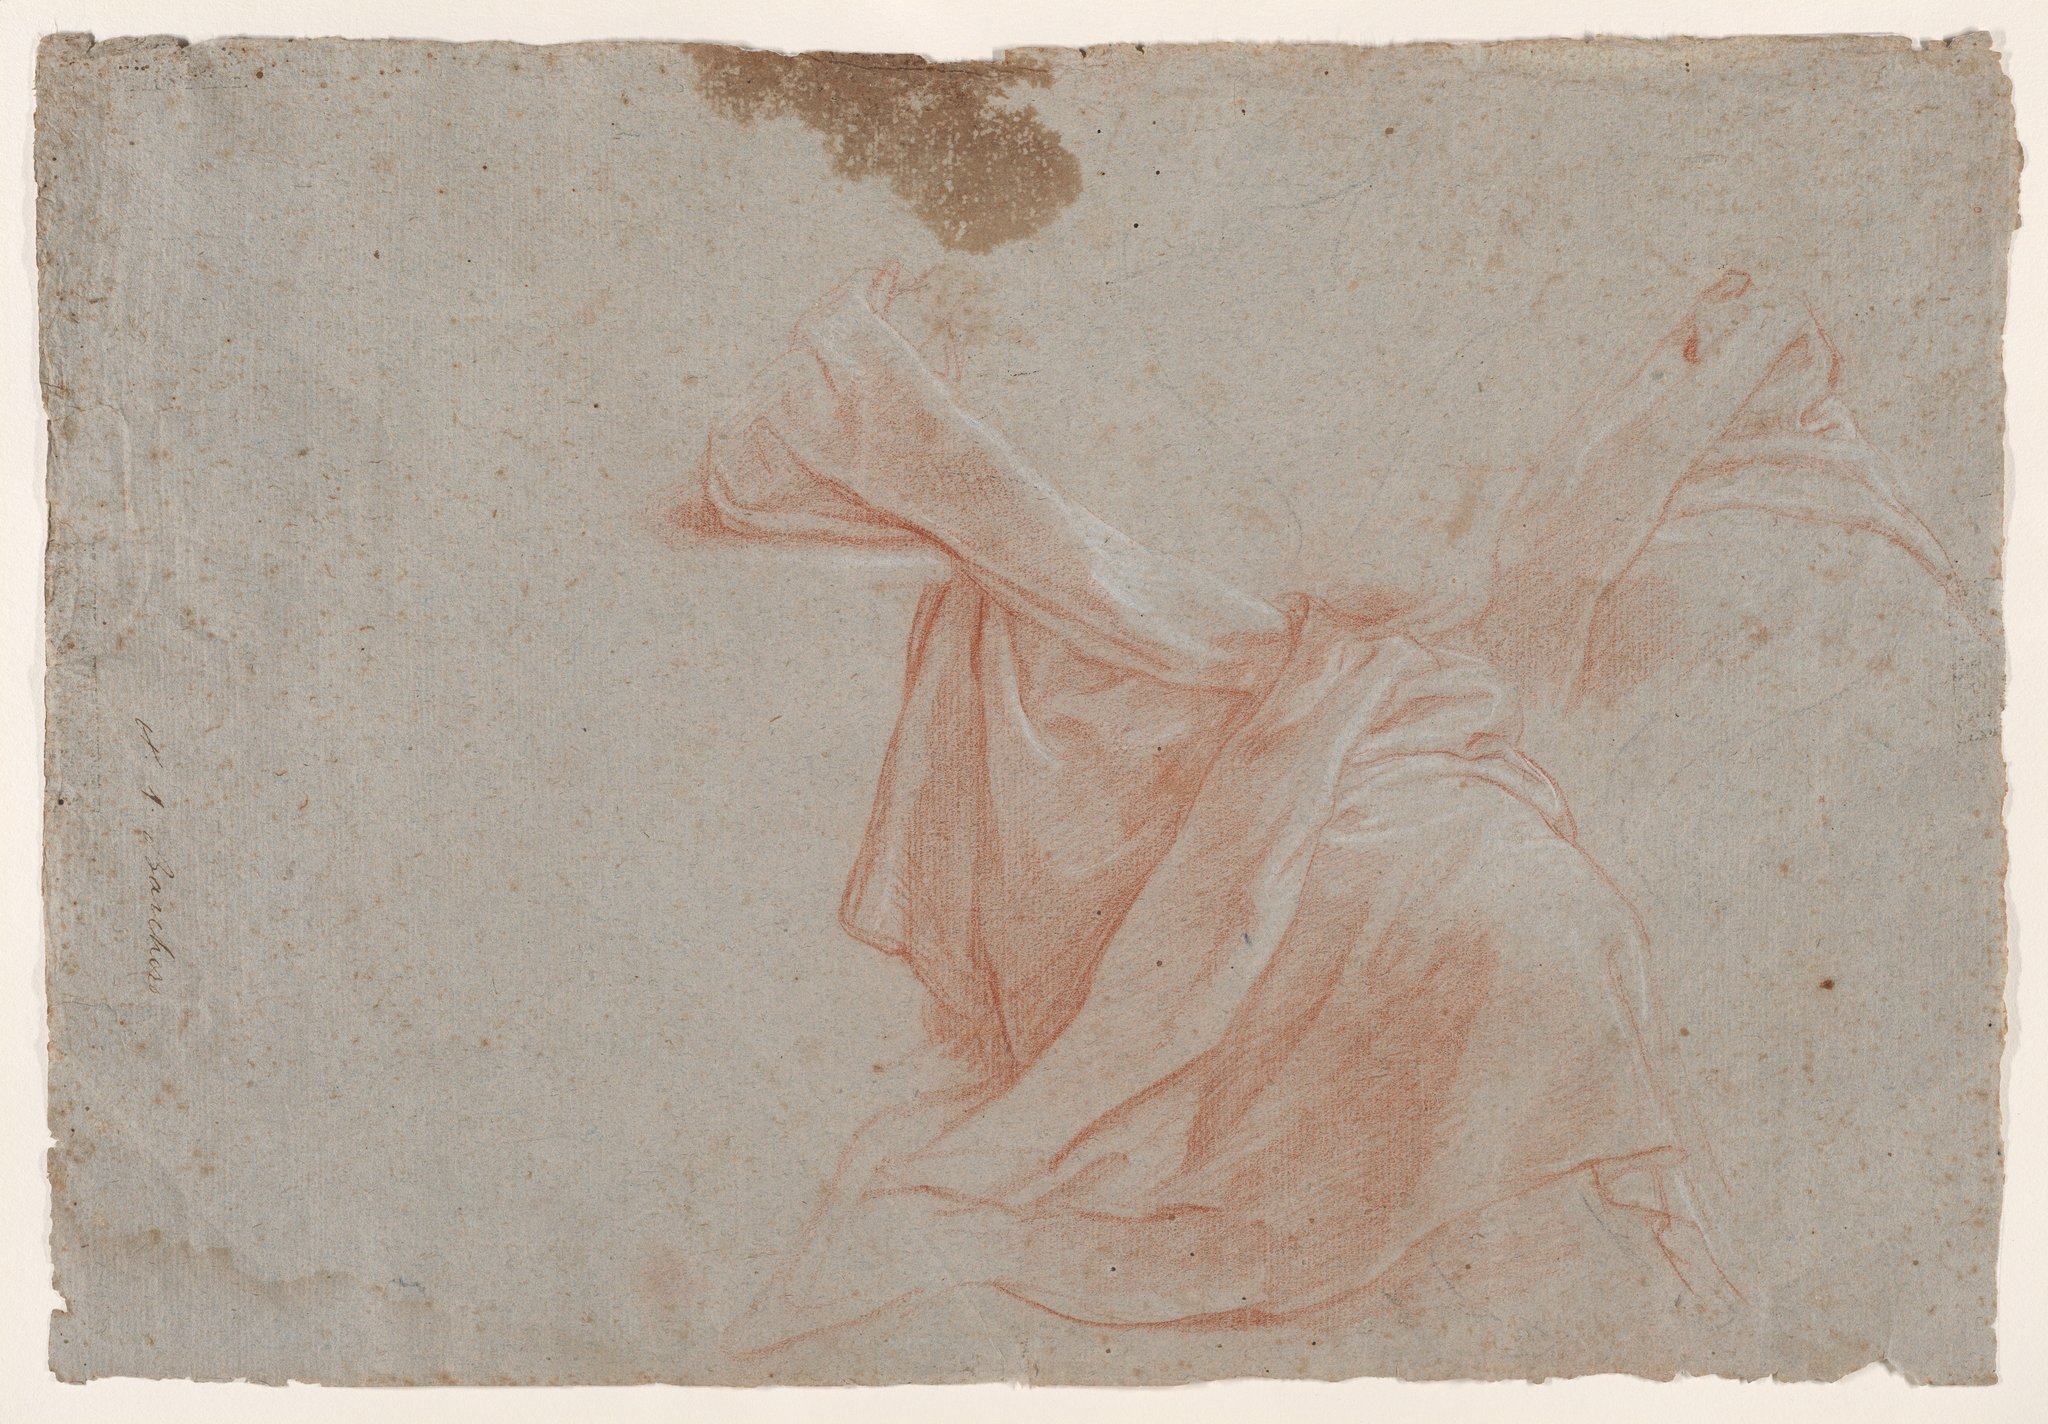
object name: drawing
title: Double-sided Sheet: (recto) Study of Draperies; (verso) Study of a Standing Female Nude in a Beckoning PoseTurned toward Left.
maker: giacomo zoboli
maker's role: artist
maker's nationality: italian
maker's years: 1681-1767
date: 1701-1800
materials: chalk